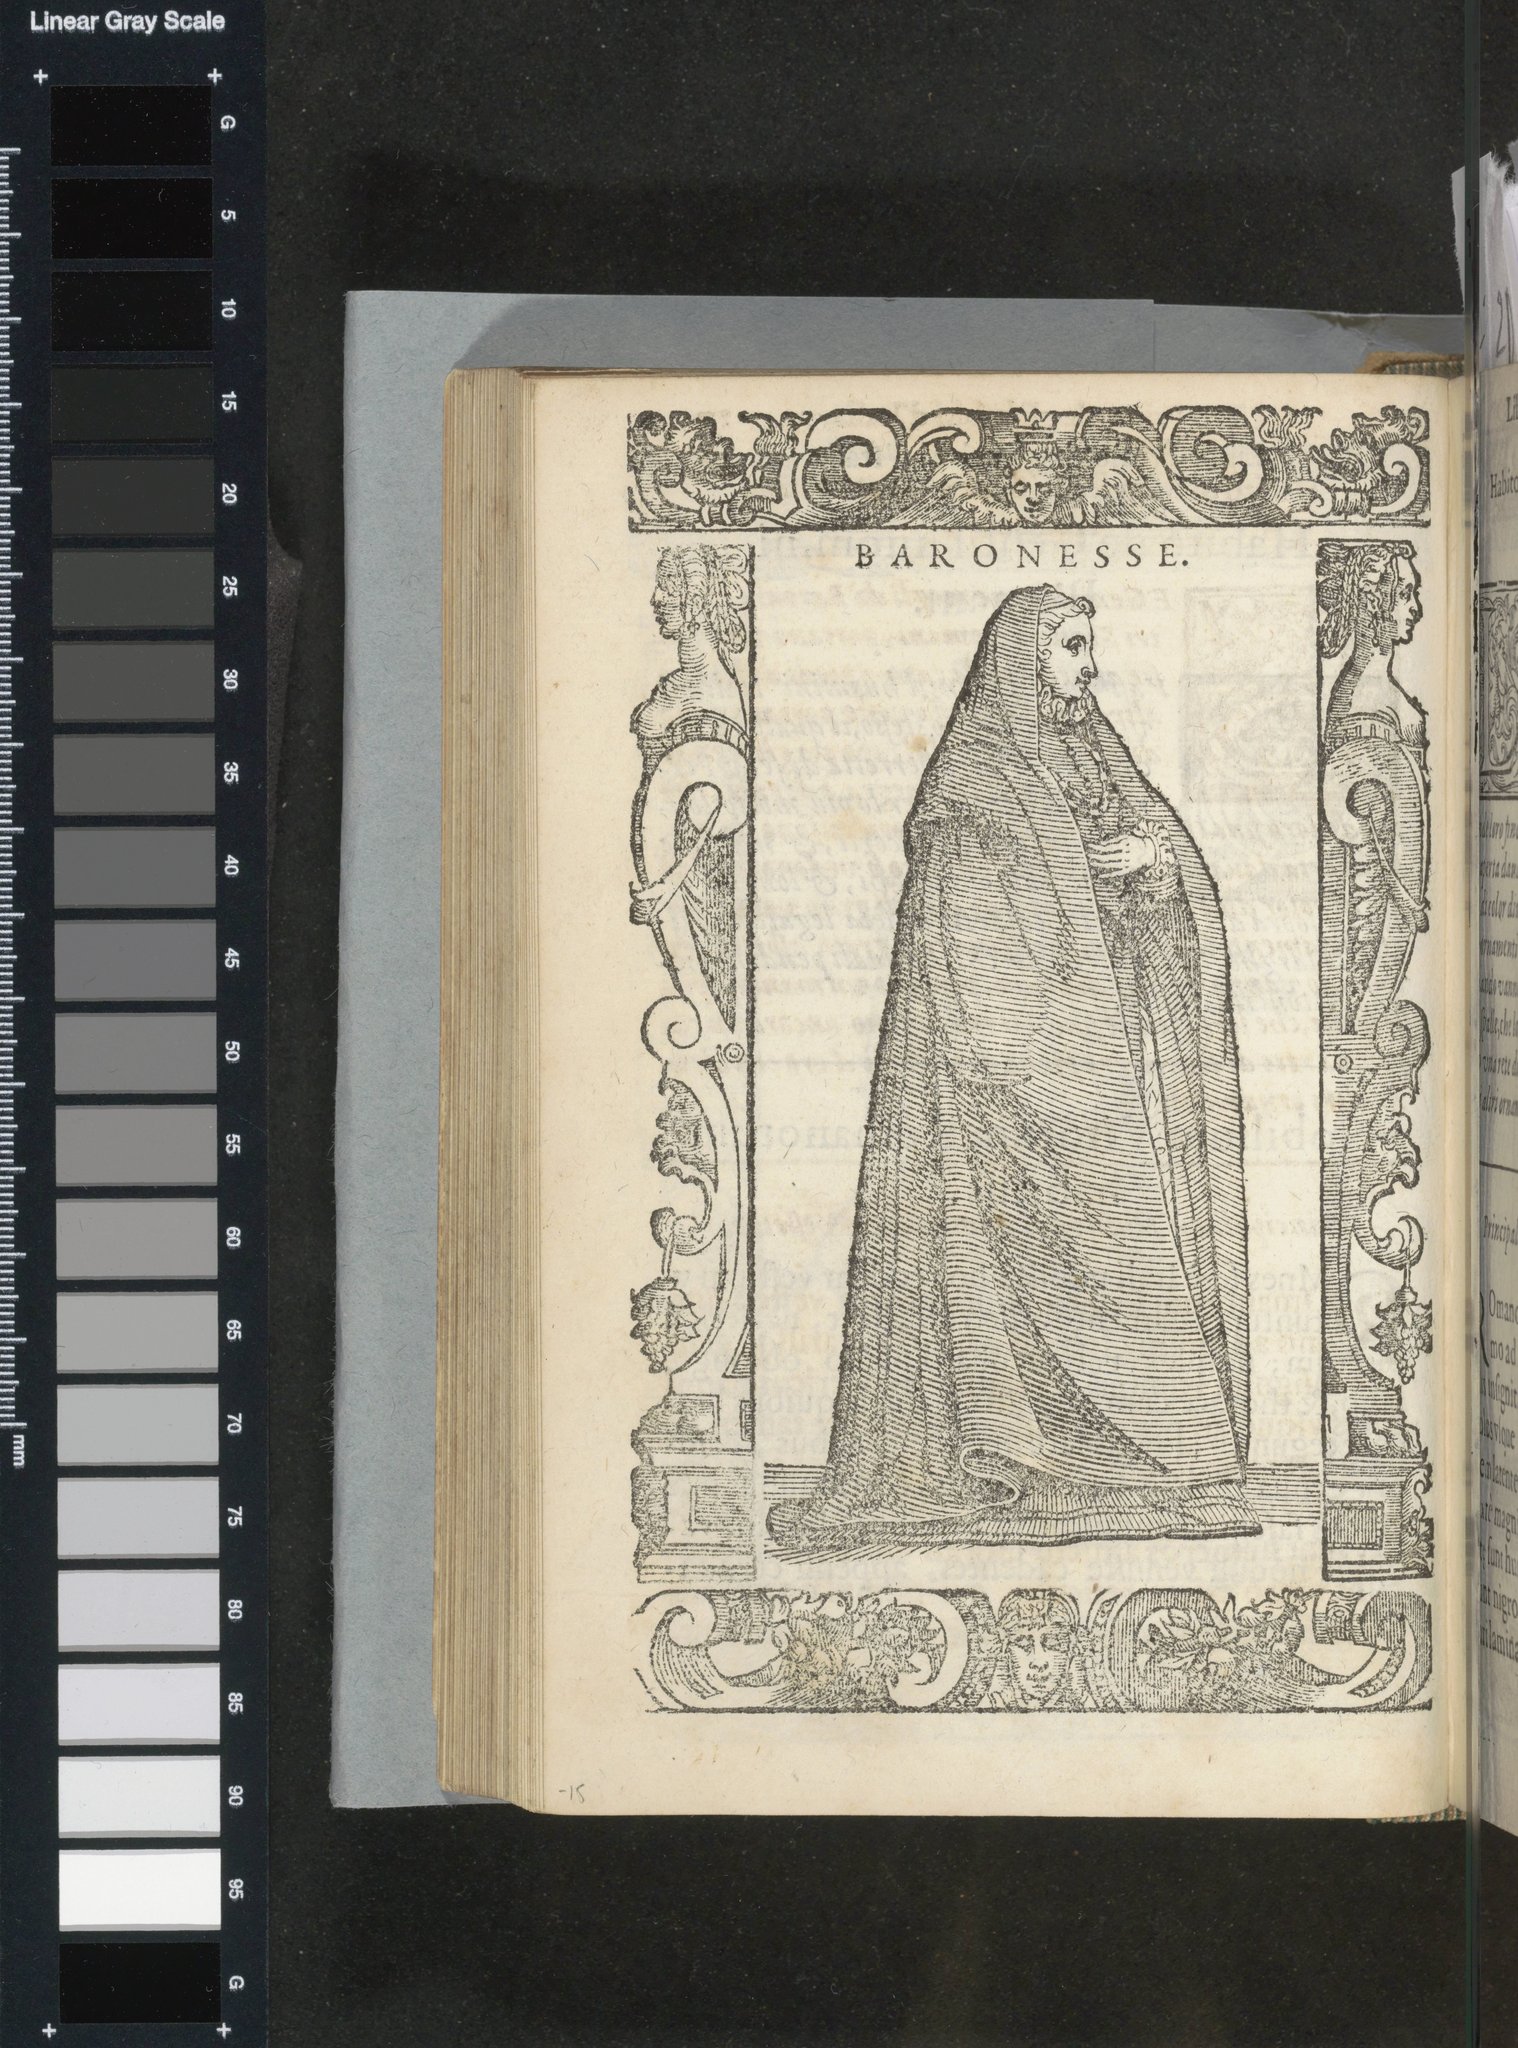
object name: costume print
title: Adellijke dame uit Rome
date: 1598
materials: paper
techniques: woodcut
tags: cape (+ women's clothes), fashion plates, mourning dress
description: Adellijke dame uit Rome in lang overkleed dat in het midden open staat, waardoor de fardegalijn zichtbaar is. Hierover een lange mantel, over het hoofd geslagen, die volgens Vecellio door weduwen werd gedragen. In ornamentrand.